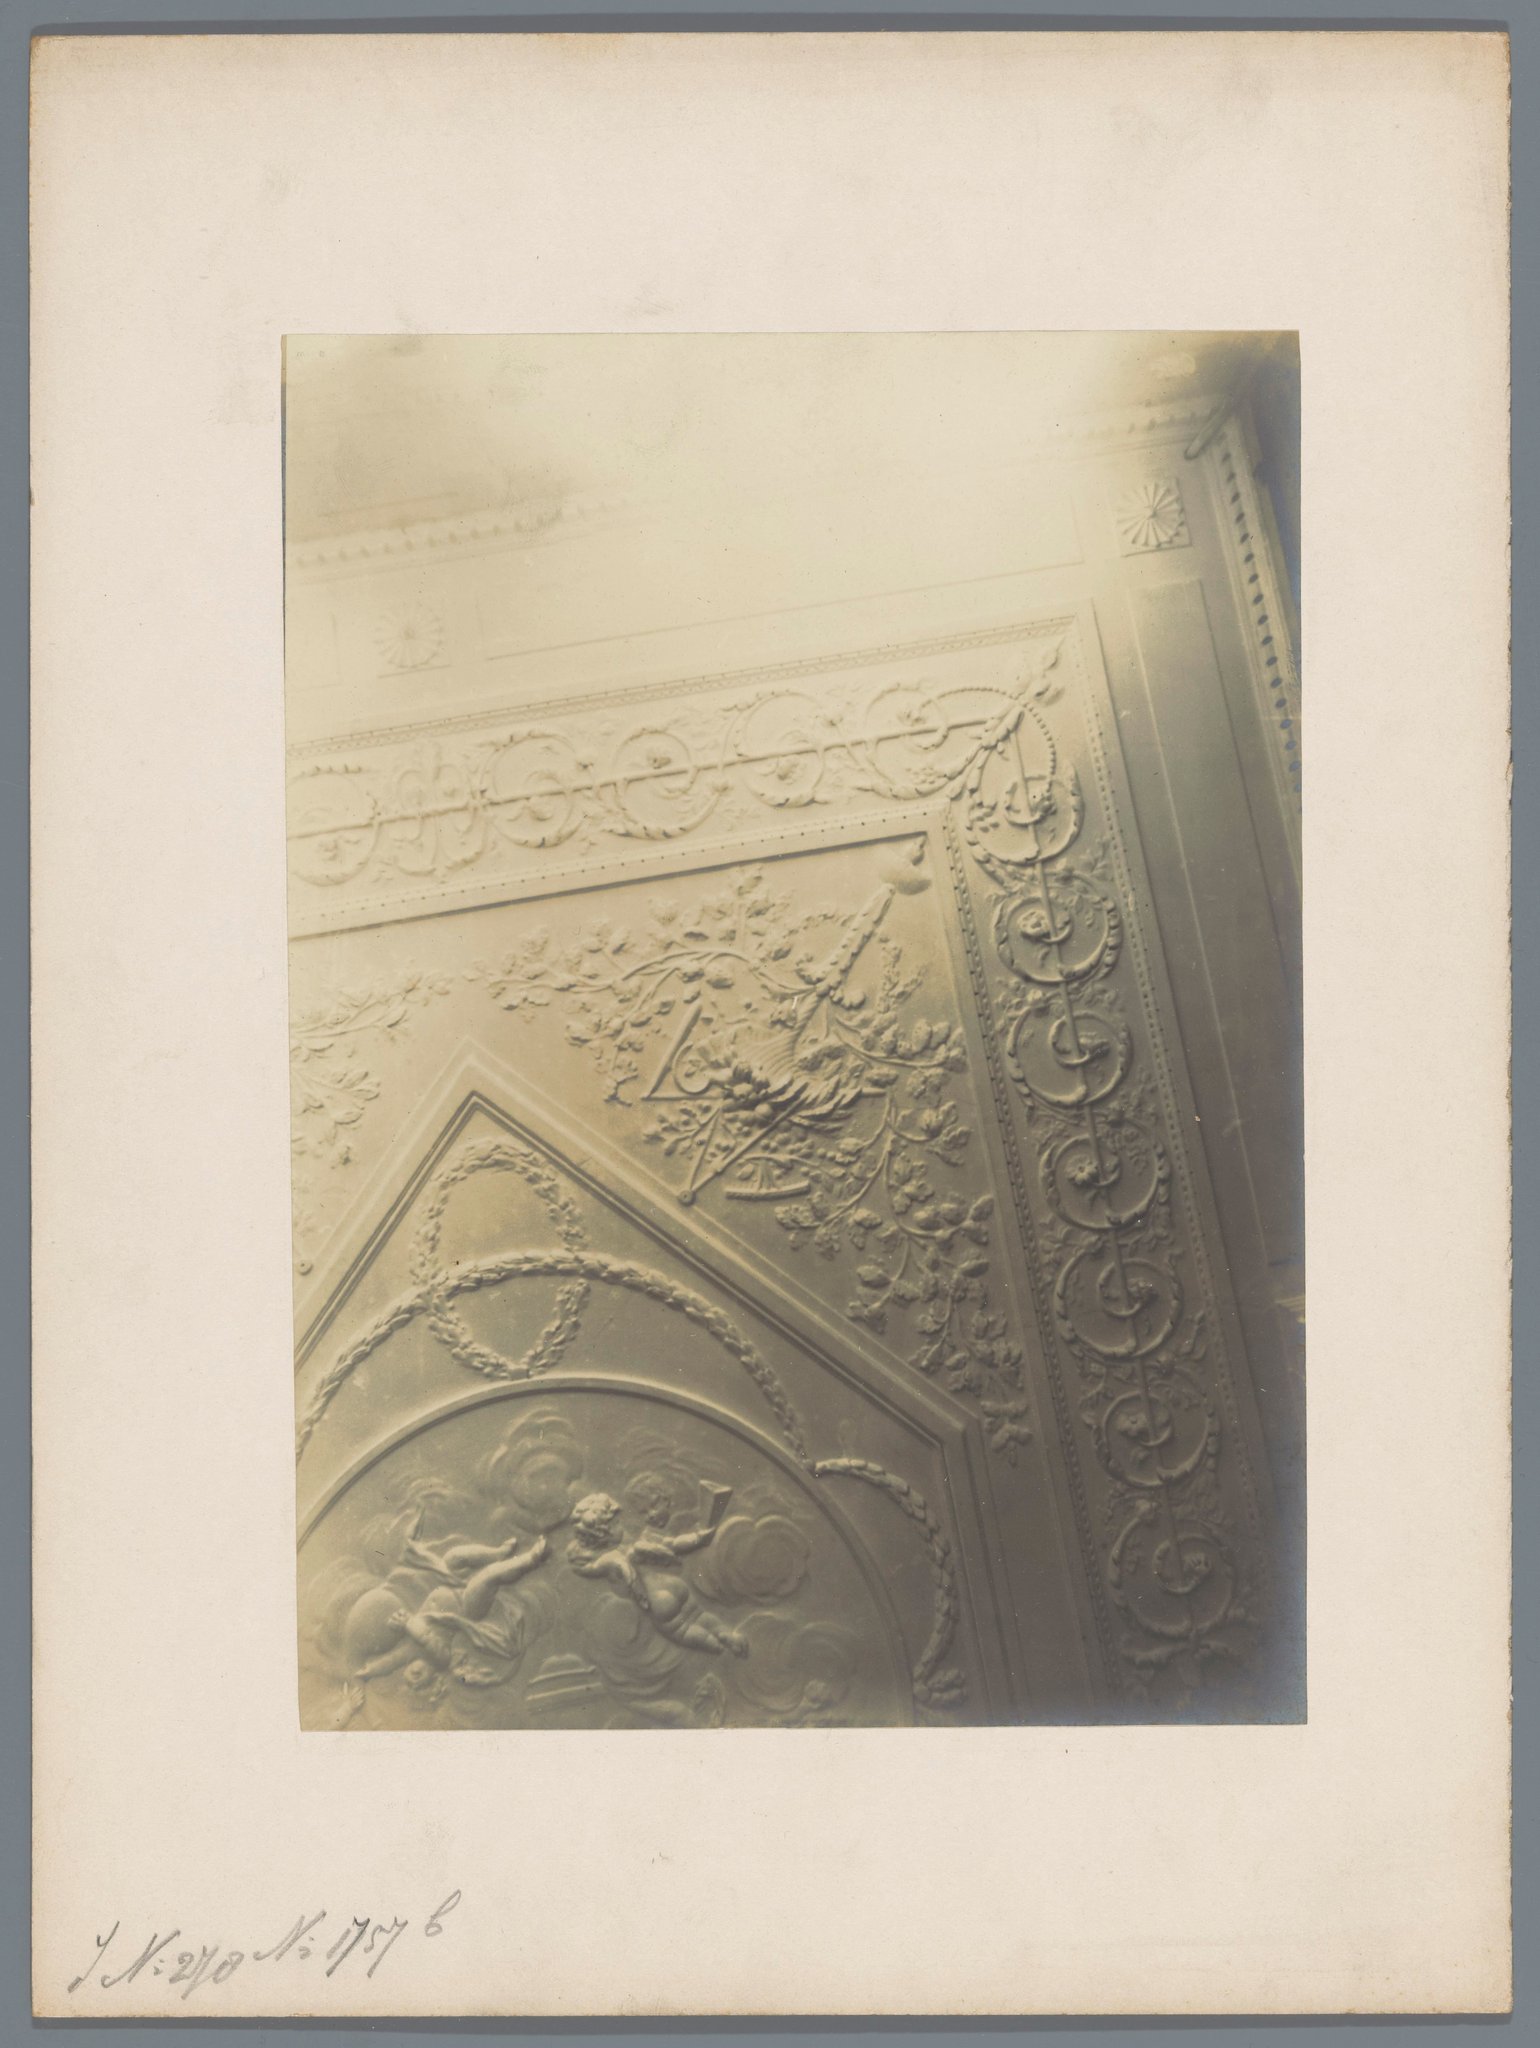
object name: photograph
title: Deel van het stuccoplafond van het huis aan de Breestraat 177 te Leiden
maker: Anonymous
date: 1902-1907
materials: cardboard, photographic support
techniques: gelatin silver print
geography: breestraat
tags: interior of the house, (decorated) ceiling, cupids: 'amores', 'amoretti', 'putti'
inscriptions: inscription: ‘Leiden, Z. H. Huis Breestraat no 177, hoek Steenschuur Plafond. Febr. 1907.’, inscription: ‘neg. no 15871 foto no 7972’, annotation